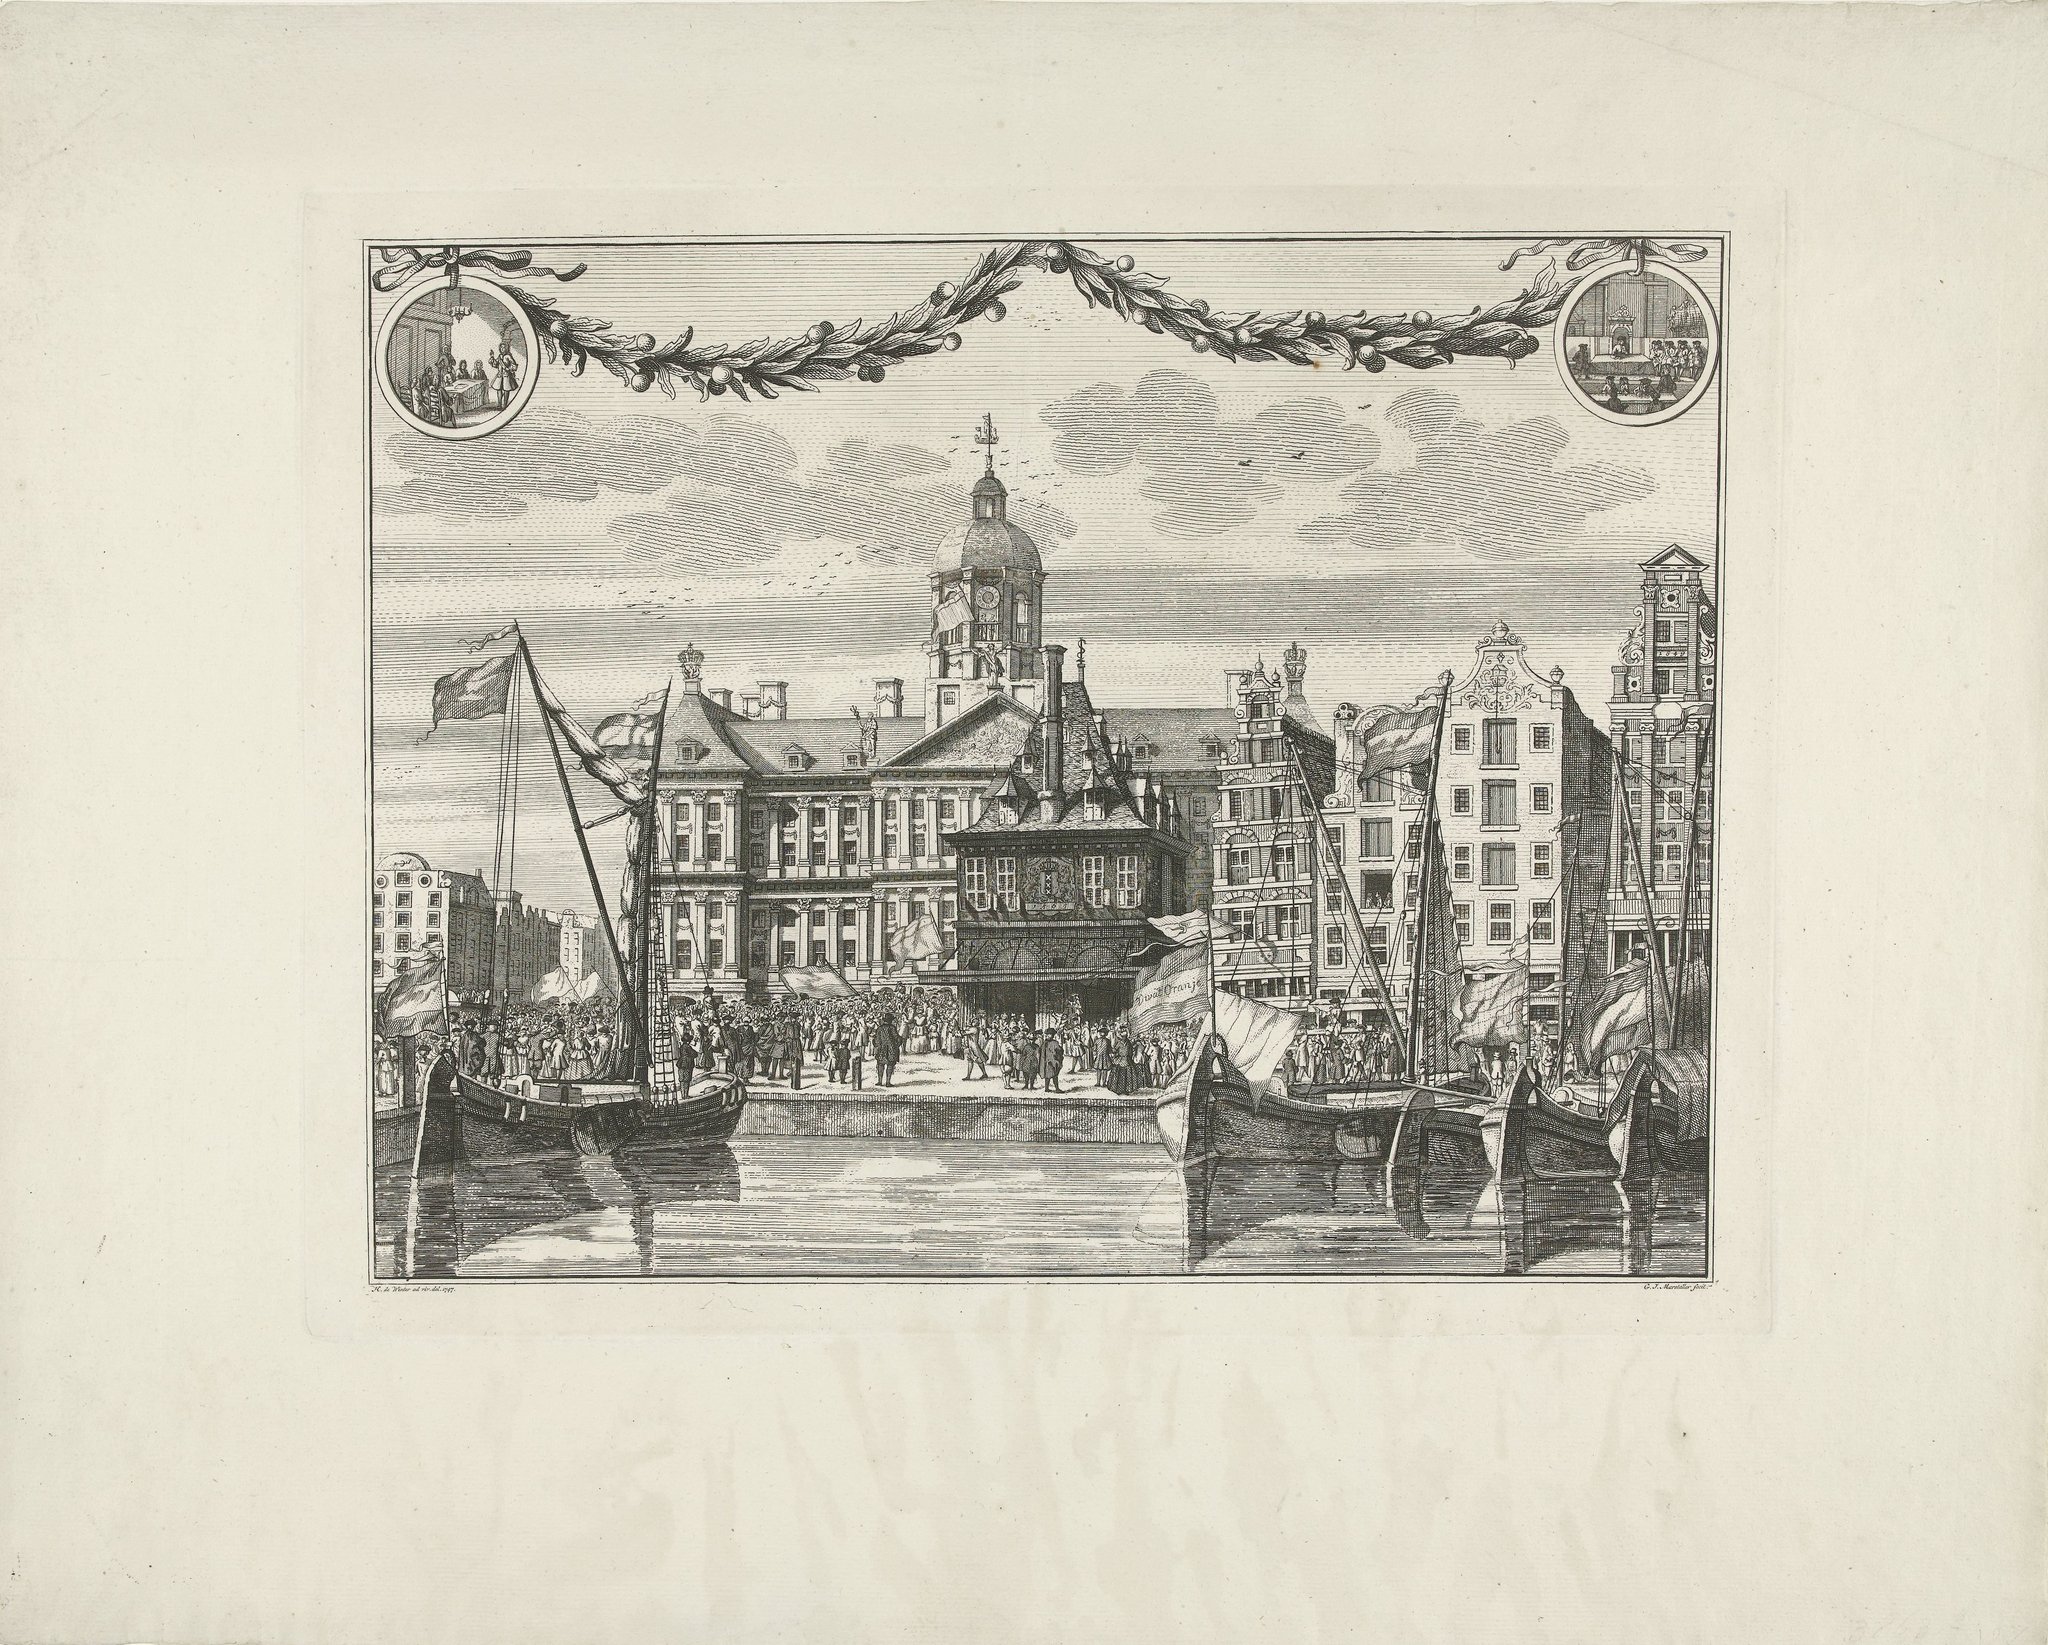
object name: print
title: Dam met Stadhuis en Waag en de uitgestoken vaandels bij de afkondiging van Willem IV als stadhouder, 2 Mei 1747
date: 1747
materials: paper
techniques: etching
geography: northern netherlands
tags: the hague, willem iv (prins van oranje-nassau), festivities on events of national importance, royal palace of amsterdam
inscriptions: collector's mark: Lugt 2228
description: Gezicht vanaf het water van de Damrak op de Dam te Amsterdam met Stadhuis en Waag versierd met uitgestoken vaandels bij de afkondiging van Willem IV als stadhouder, 2 Mei 1747. Bovenaan een oranjetak en twee medaillons van de inzwering van de stadhouder.